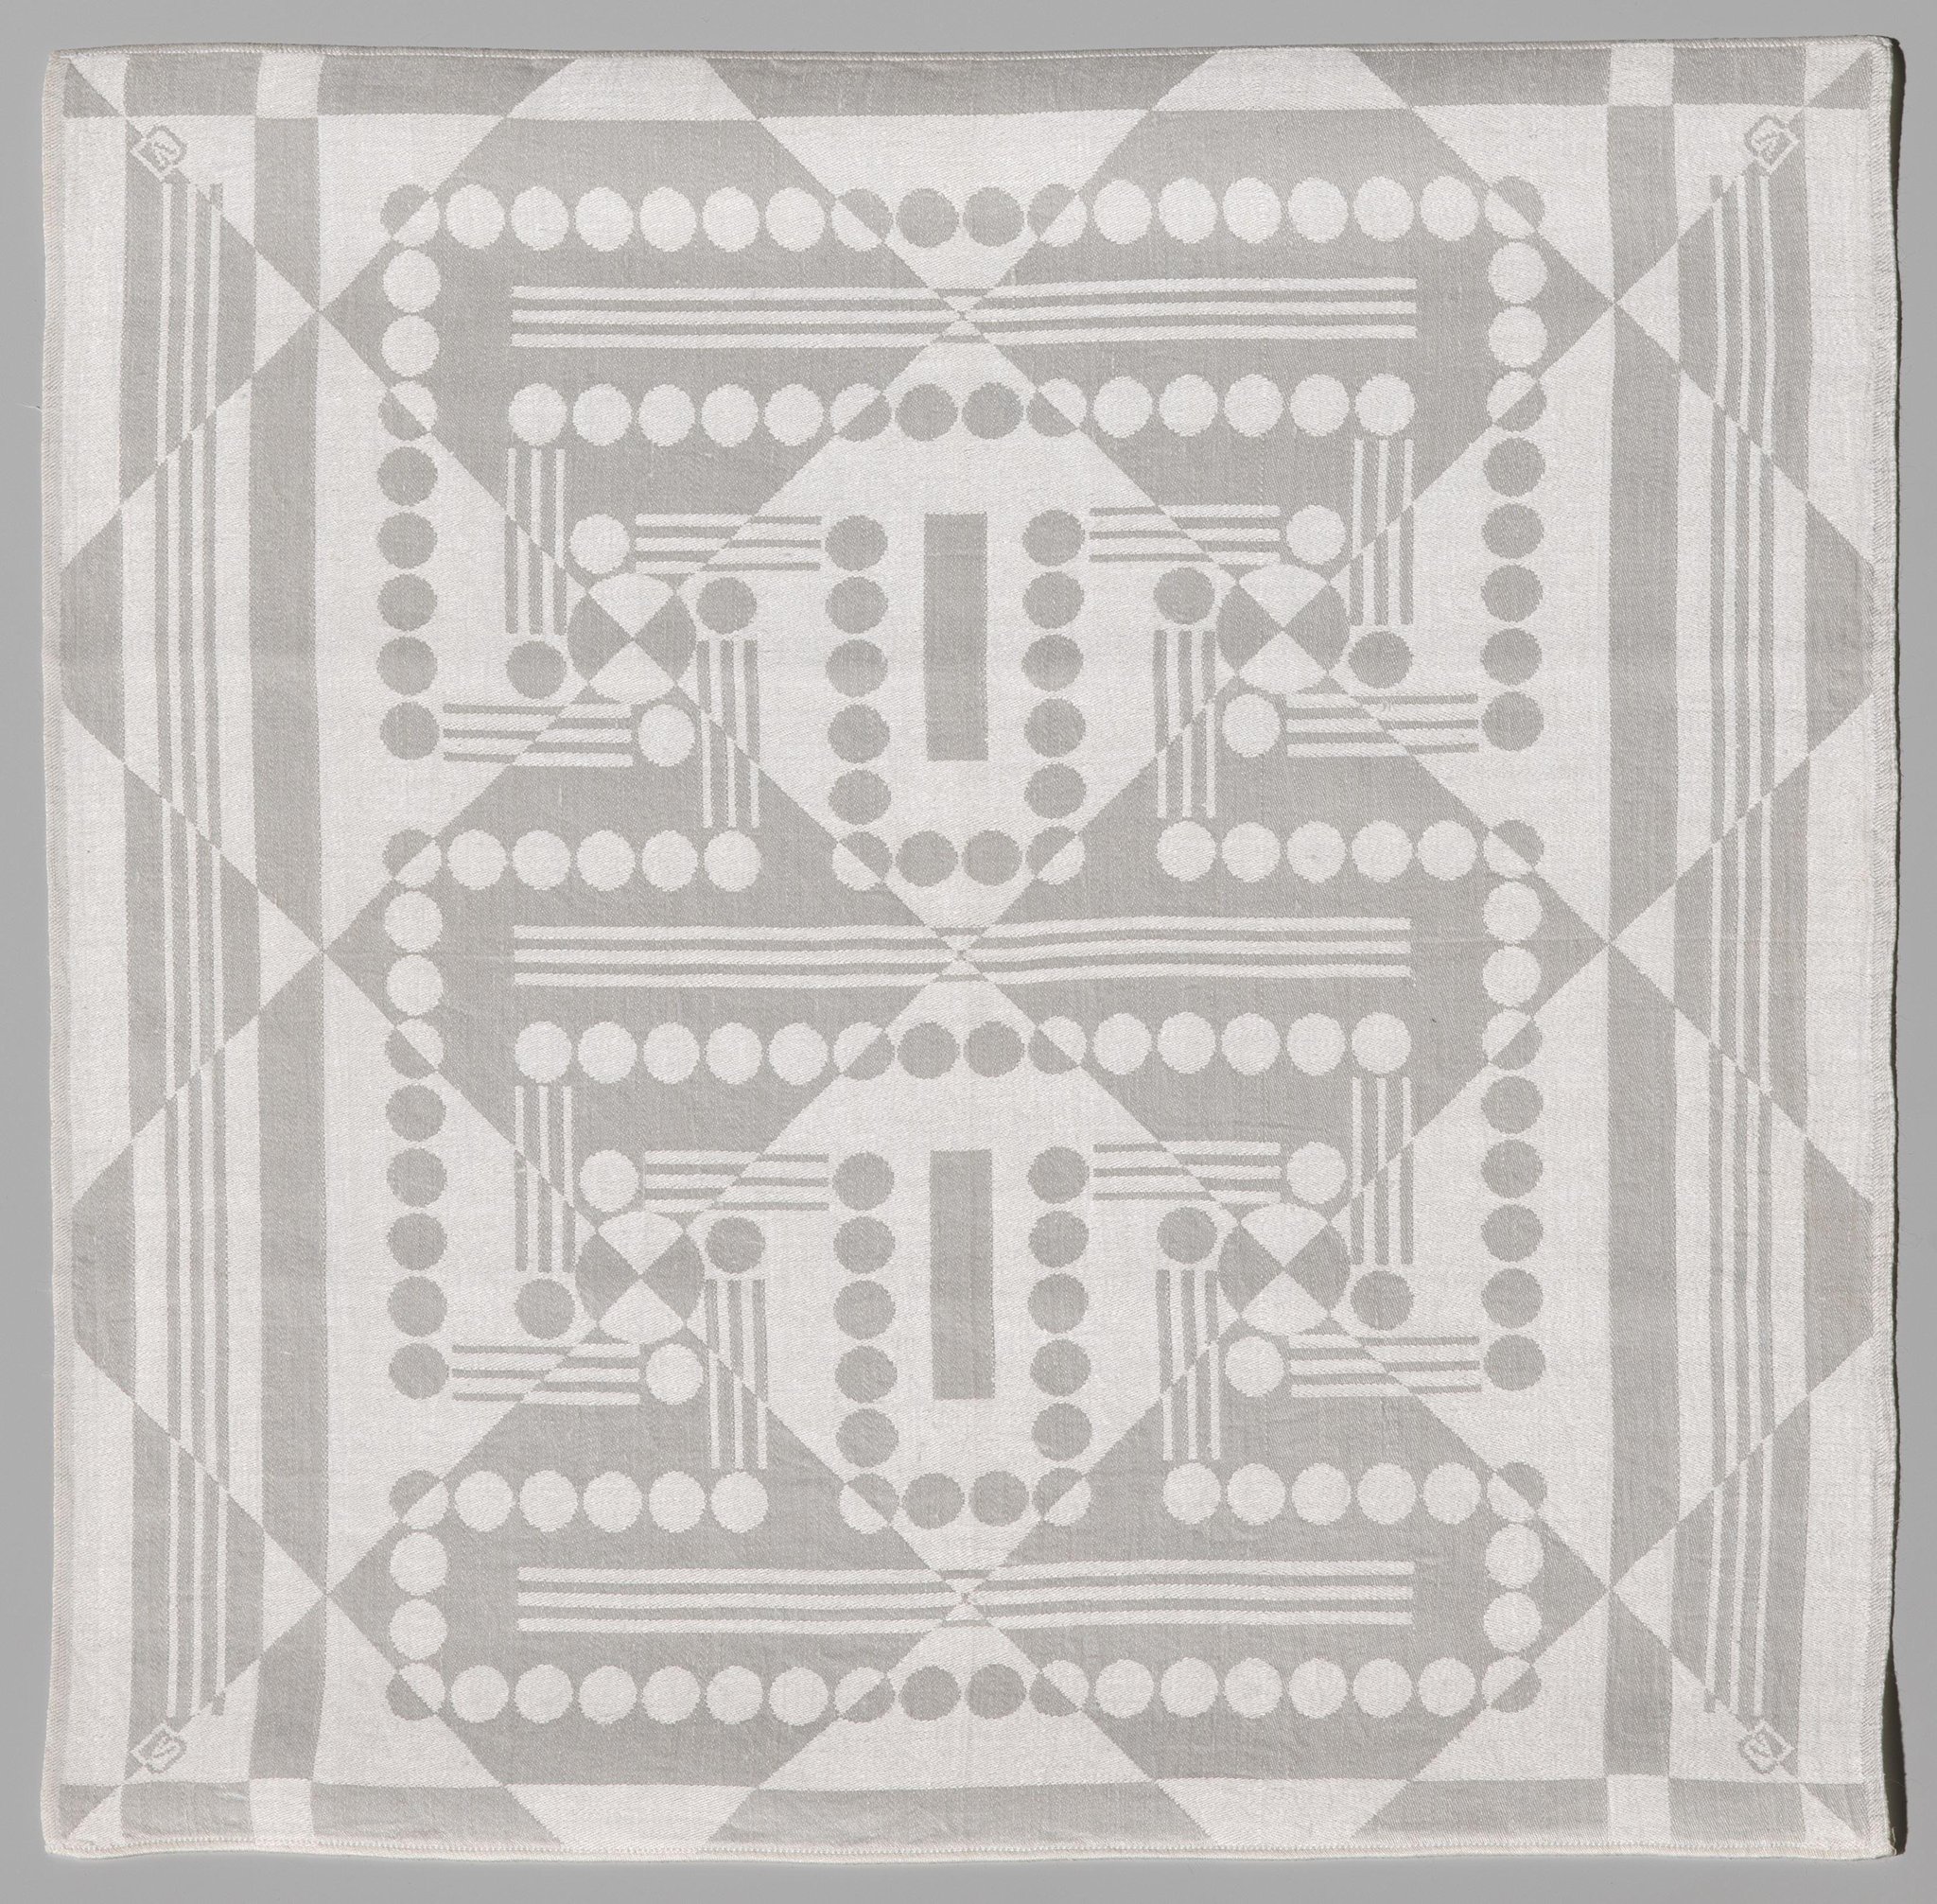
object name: napkin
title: Vingerdoek van linnen met geometrisch dessin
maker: chris lebeau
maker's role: draughtsman, print maker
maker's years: 1878-1945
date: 1888-1945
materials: linen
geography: eindhoven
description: Vingerdoek van linnen met geometrisch dessin